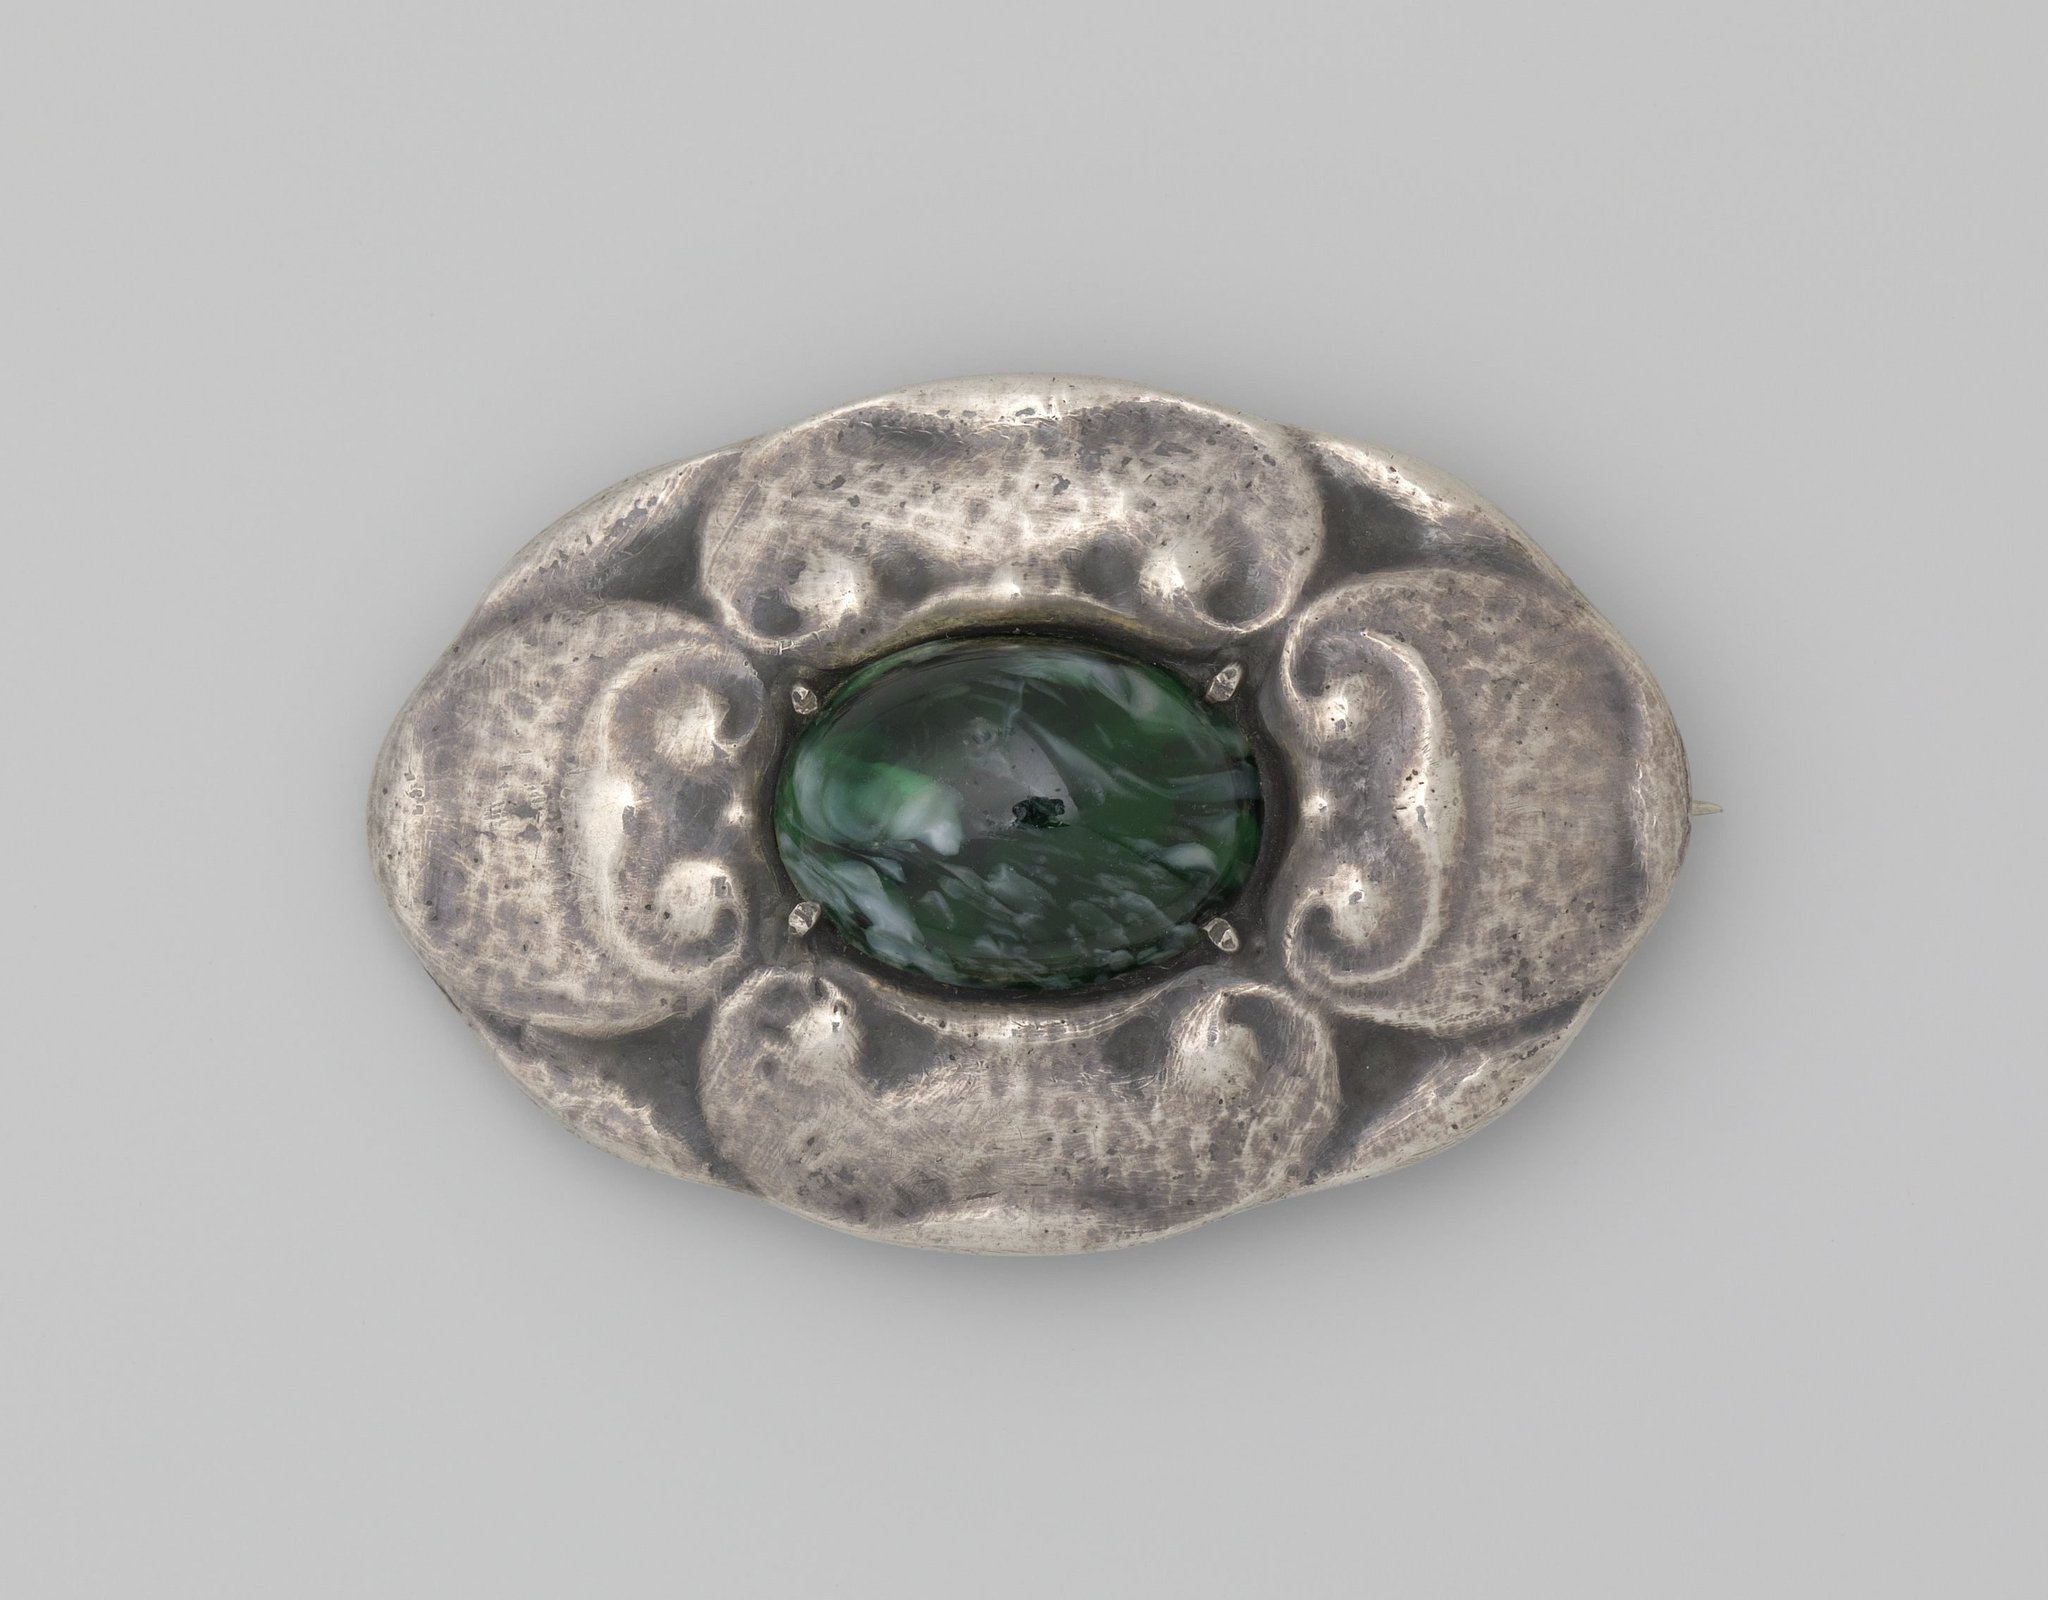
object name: brooch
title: Ovale broche van zilver met groen glas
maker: p. heerens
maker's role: designer, jeweler, silversmith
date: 1916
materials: glass, silver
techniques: hammering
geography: schoonhoven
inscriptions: alloy mark: ‘(oud) zwaard’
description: Ovale broche van gehamerd zilver met in het midden een groen glas voorzien van een haaksluiting.